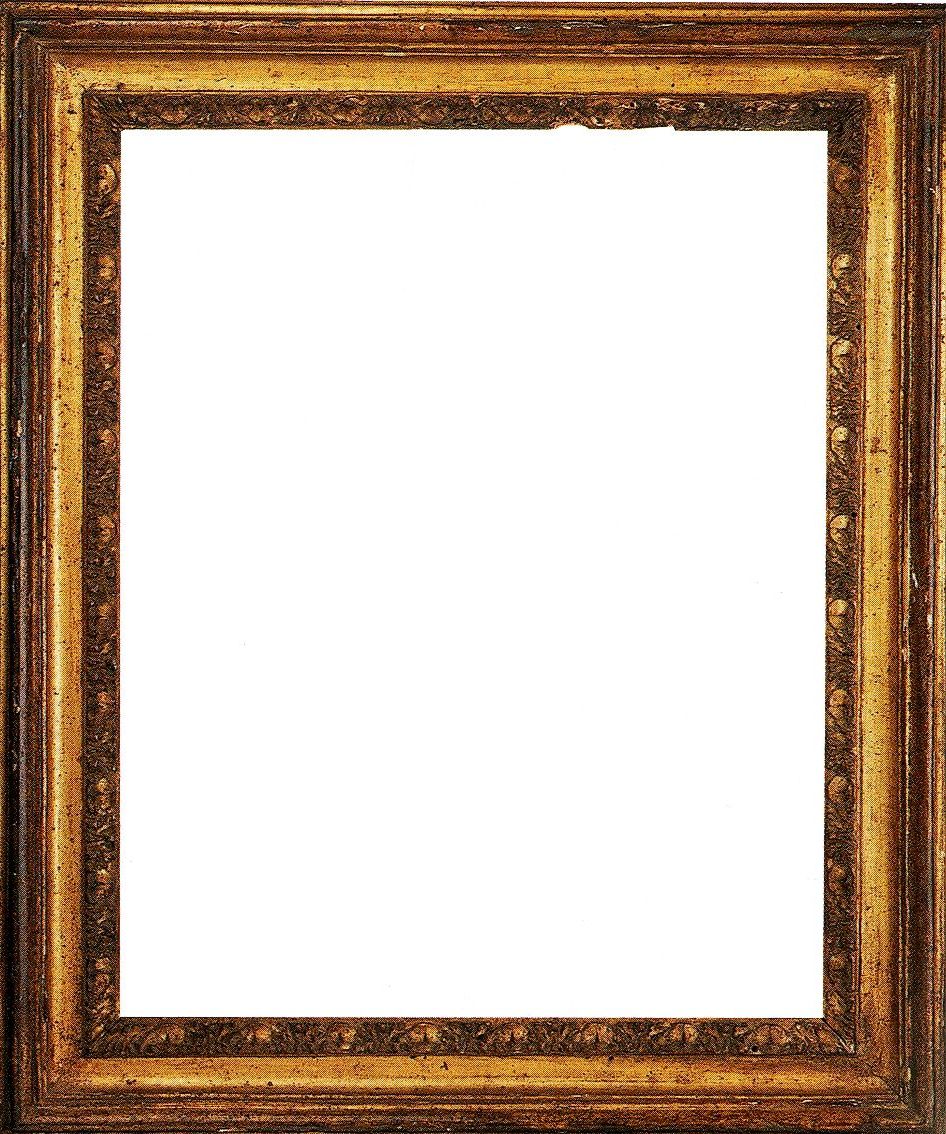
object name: frame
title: Salvator Rosa frame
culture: italian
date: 1740-1755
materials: wood